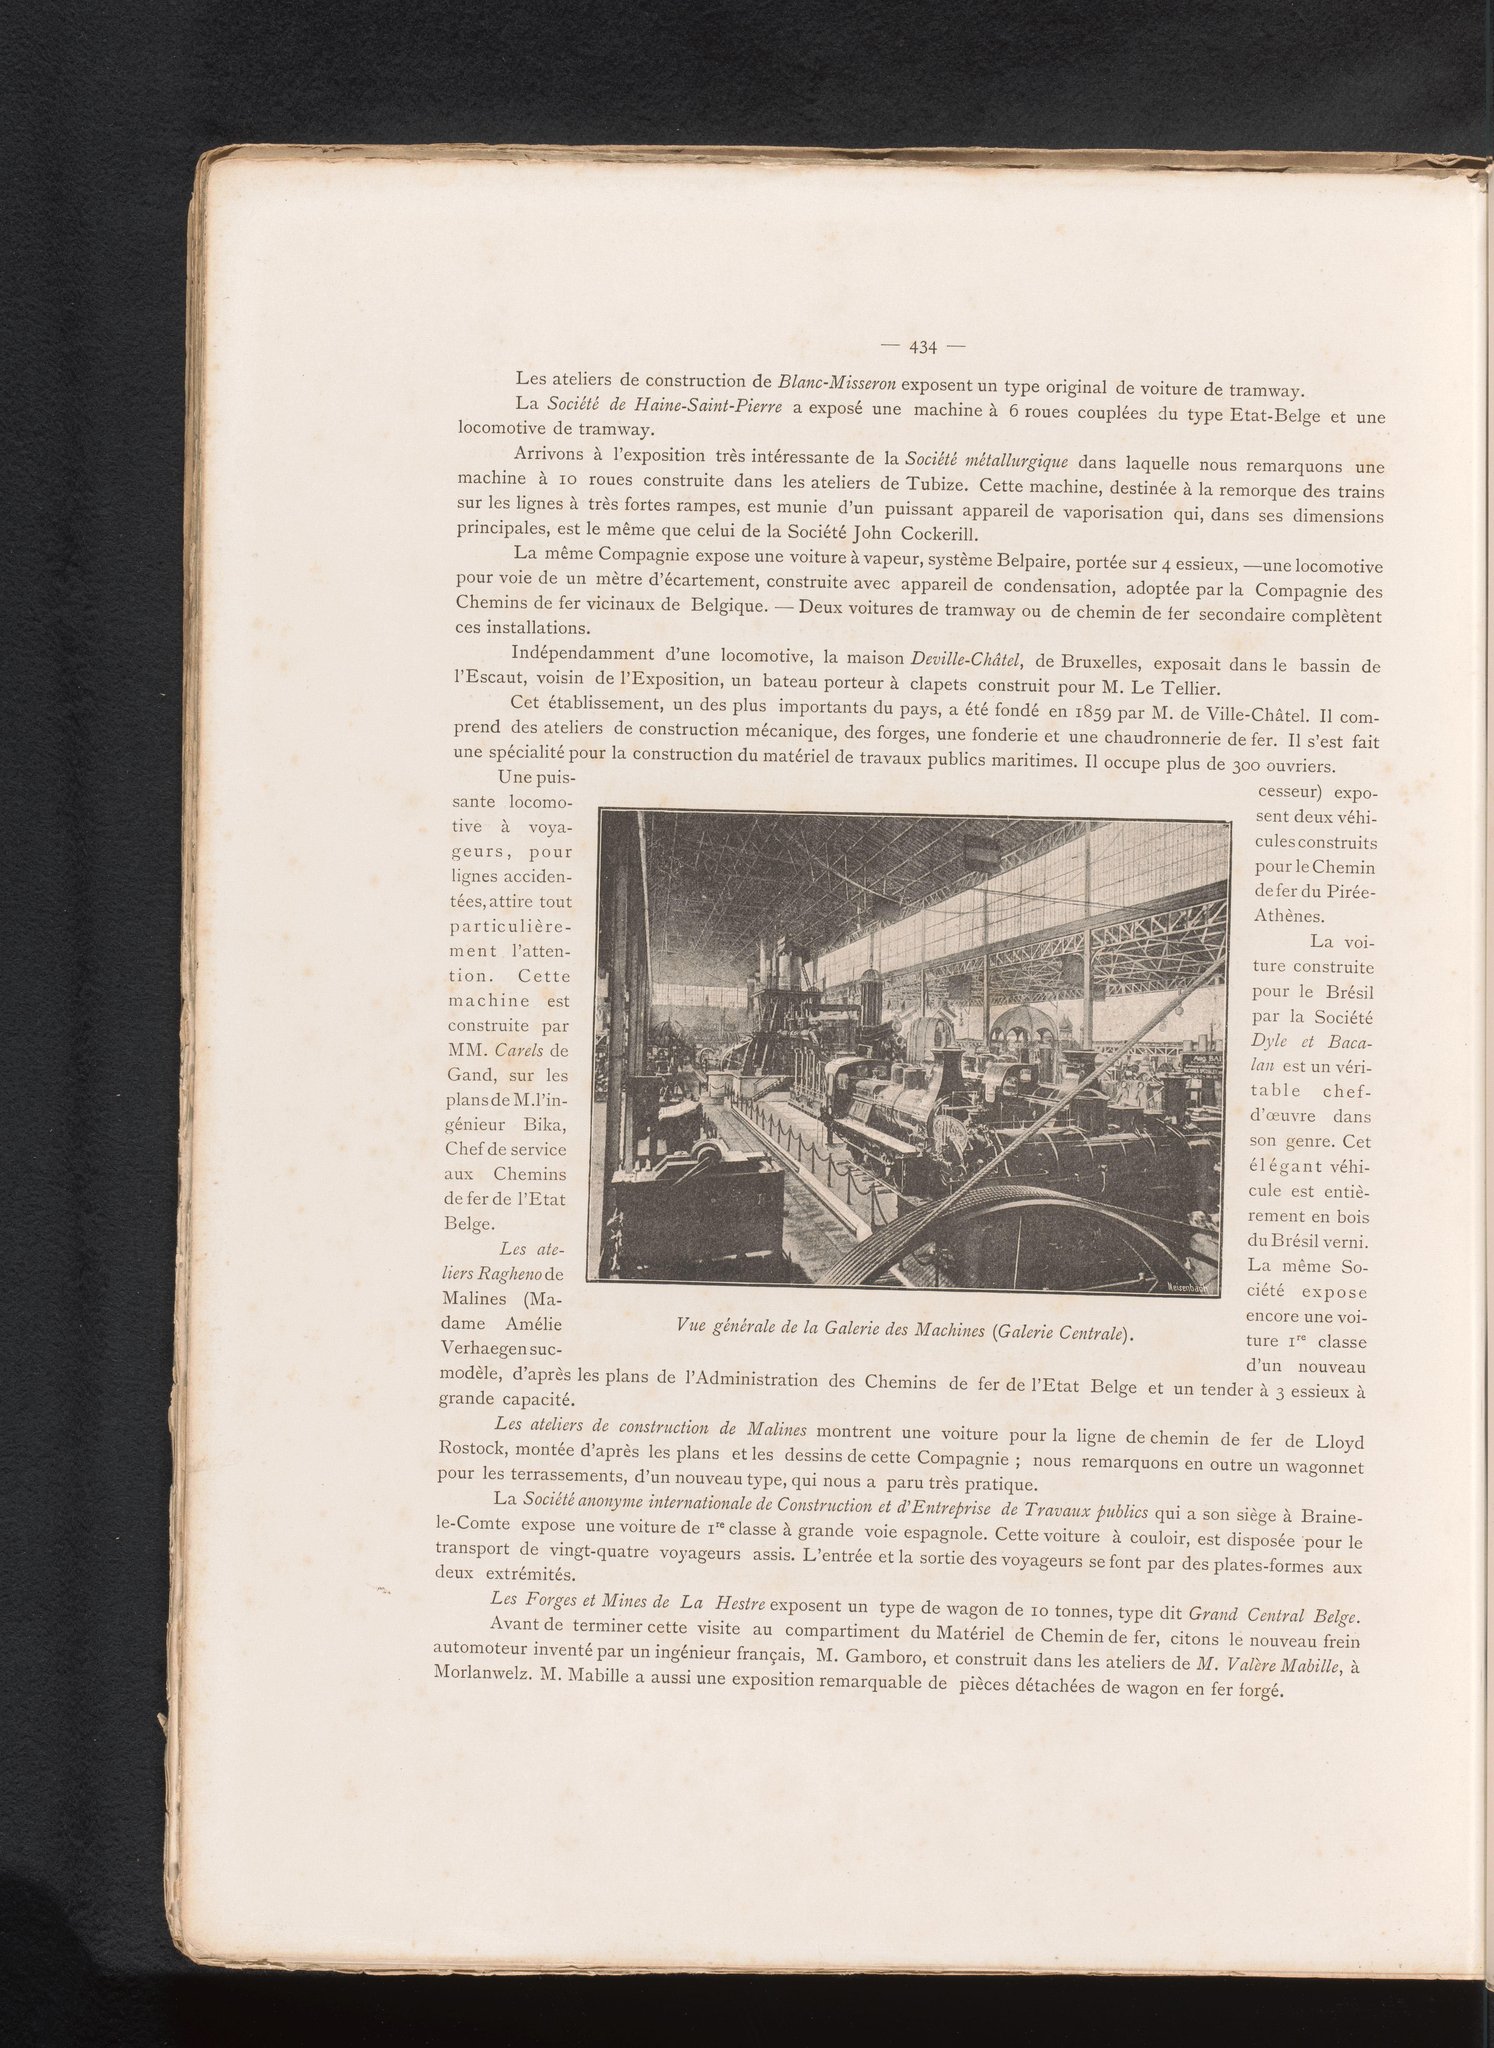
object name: photomechanical print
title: Gezicht op de galerij met machines op de Wereldtentoonstelling van 1885 in Antwerpen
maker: Anonymous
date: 1880-1885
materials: paper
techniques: autotype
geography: antwerp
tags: world fair, world exhibition, antwerp